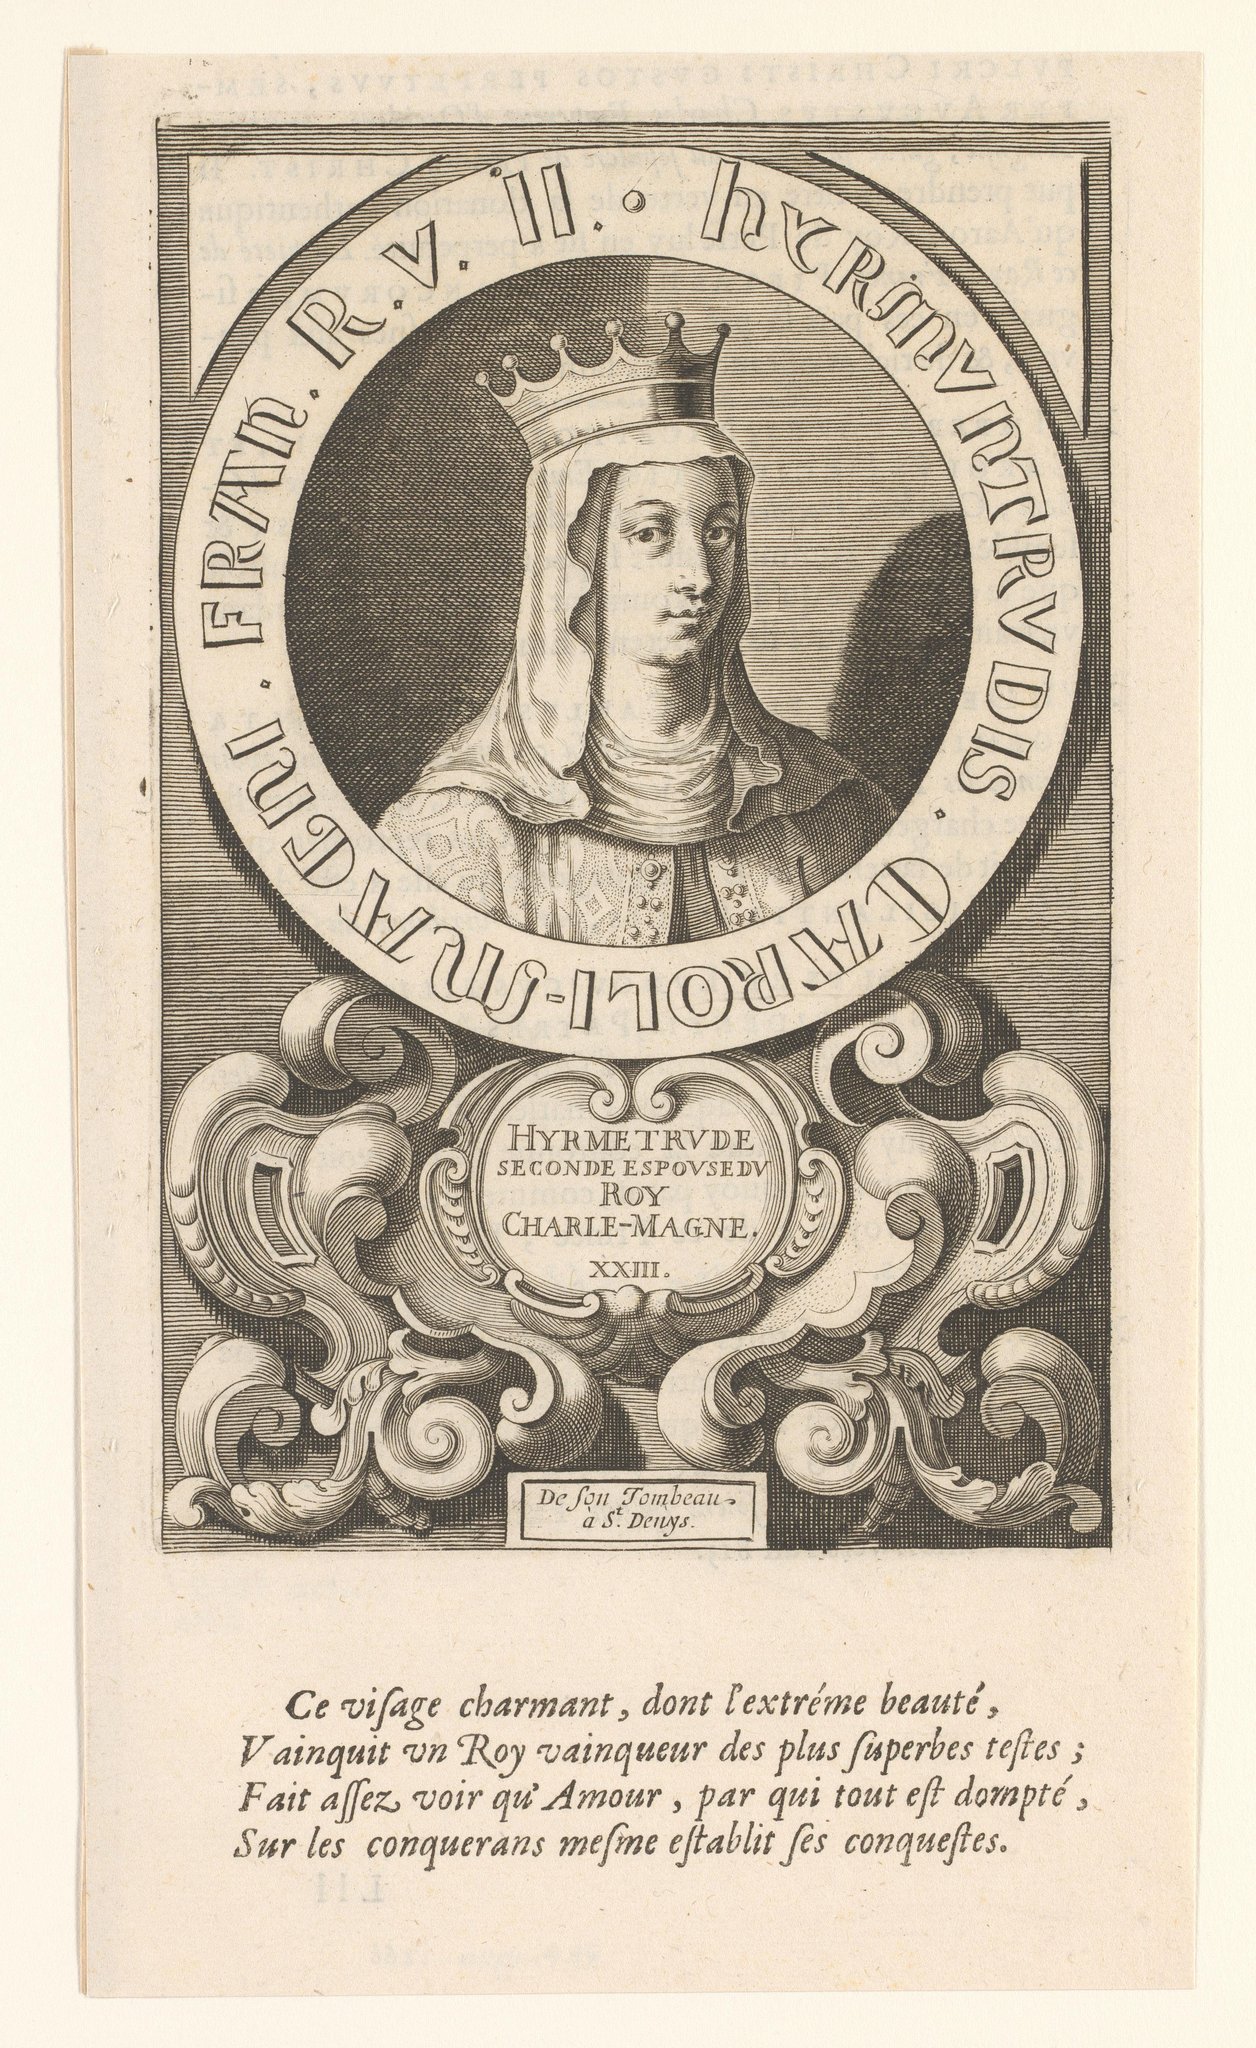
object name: print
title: Hyrmetrude seconde espouse du roy Charle-Magne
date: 1643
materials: paper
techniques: engraving, letterpress printing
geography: paris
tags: historical persons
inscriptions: collector's mark: Lugt 2228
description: Prent uit: Eudes de Mézeray, François. Histoire de France, depuis Faramond jusqu’au regne de Louis le Juste (...). 3 dln. Parijs: Mathieu Guillemot, 1643, dl. 1. Prent waarschijnlijk voor het eerst verschenen in: Bie, Jacques de. Les vrais portraits des rois de France (...). Parijs: Jacques de Bie en Pierre Rocolet, 1634. Prent ook gebruikt in latere publicaties.